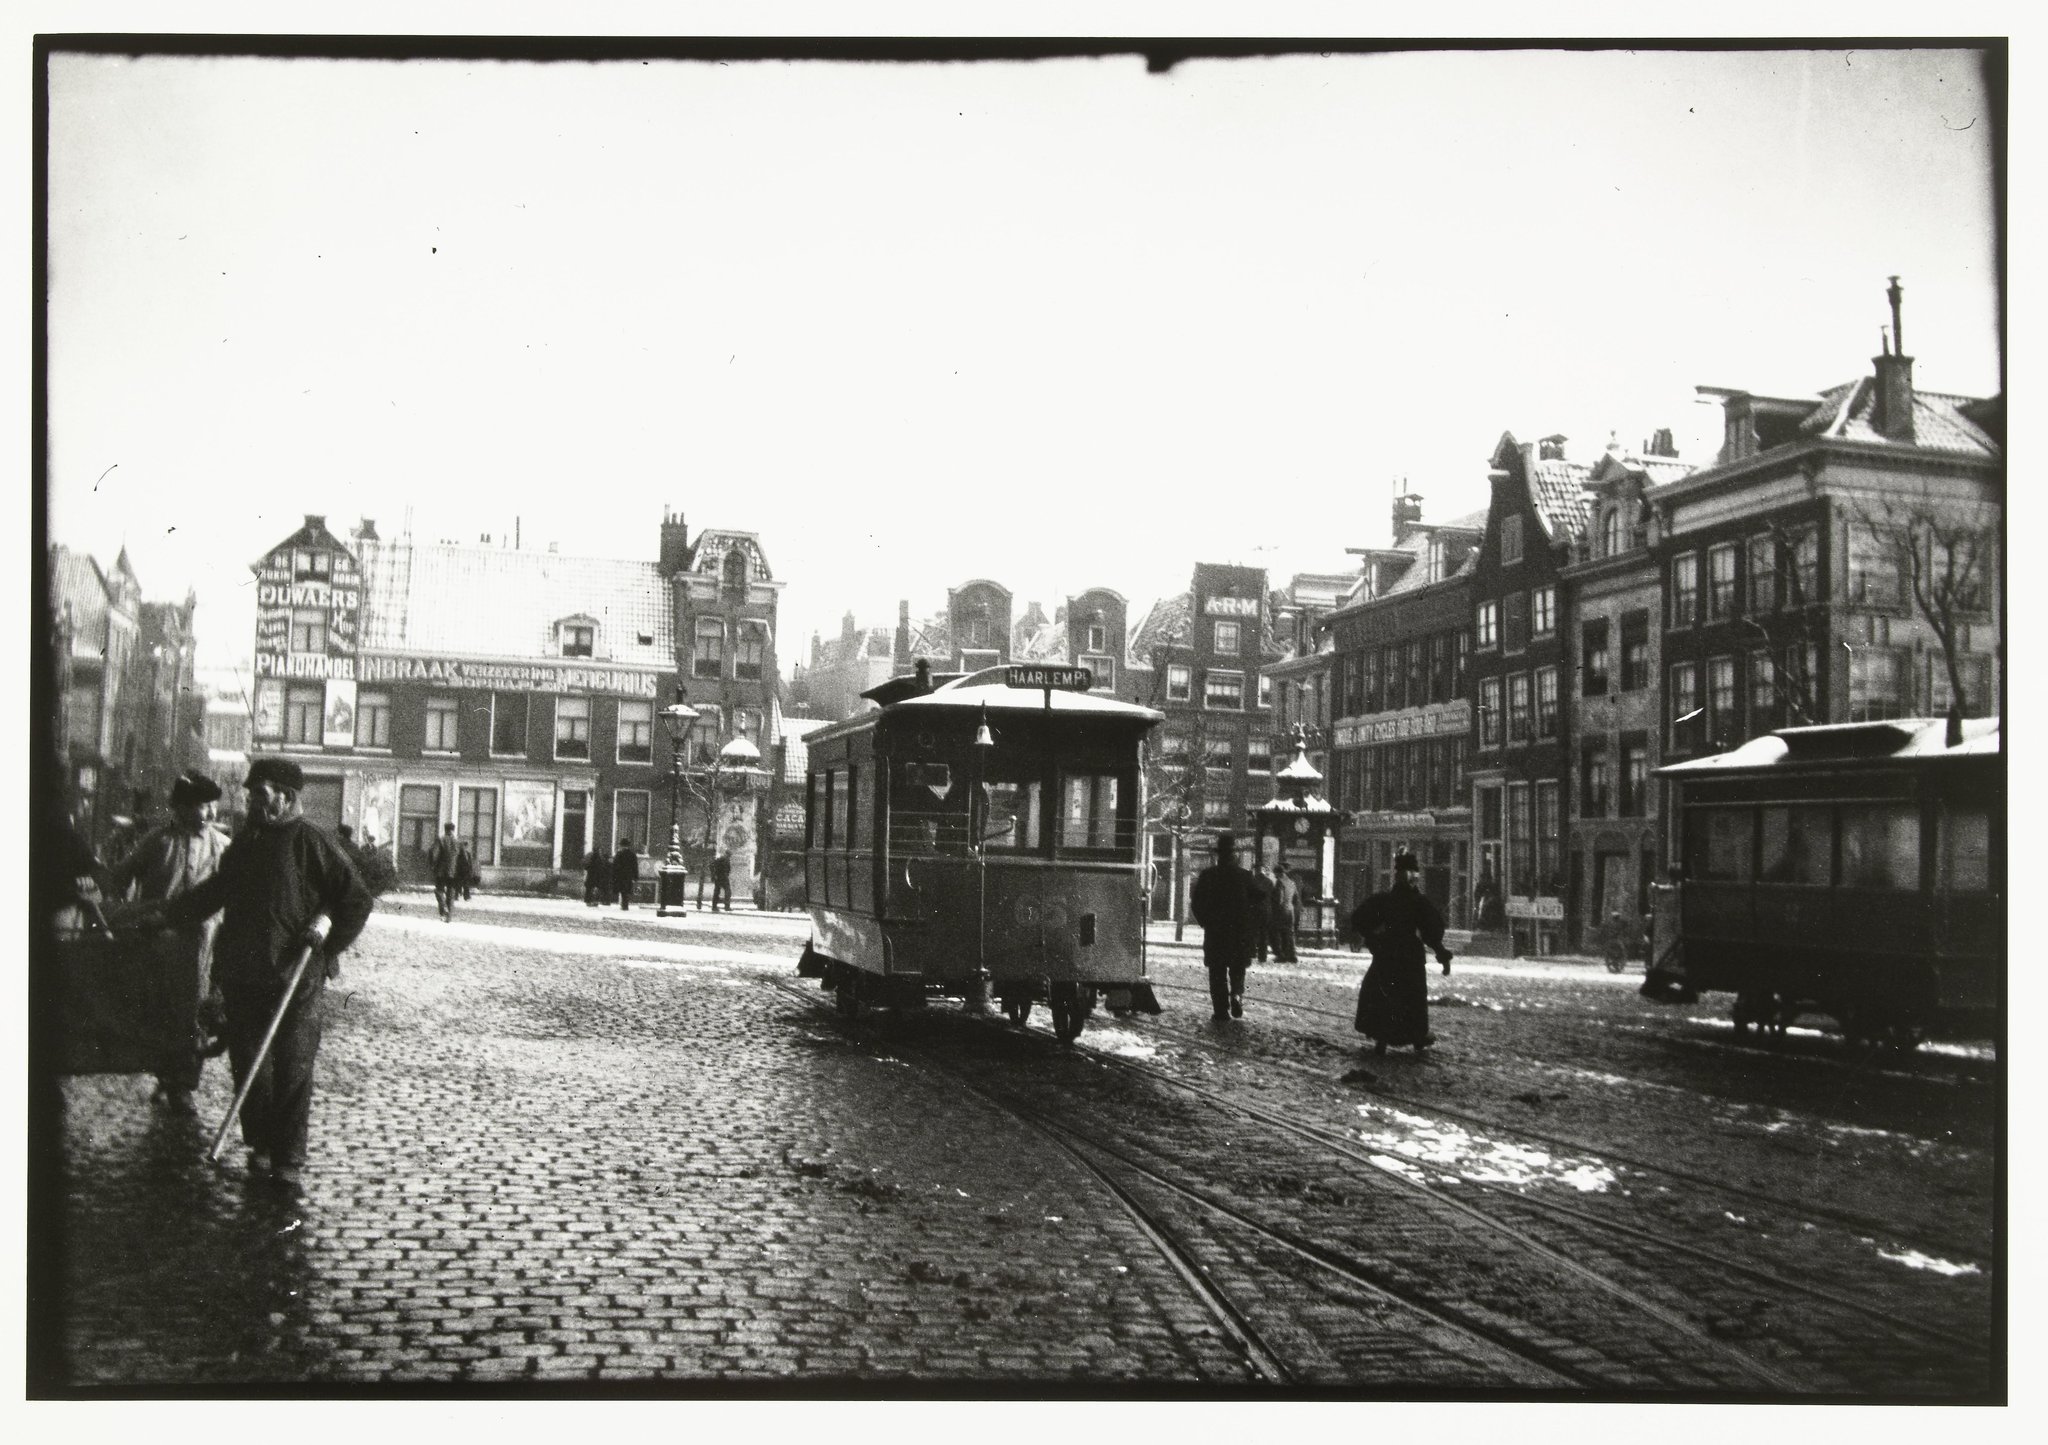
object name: photograph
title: Gezicht op het Leidseplein in Amsterdam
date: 1890-1910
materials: paper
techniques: gelatin silver print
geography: netherlands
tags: leidseplein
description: Moderne afdruk van negatief BR 995 (collectie RKD).